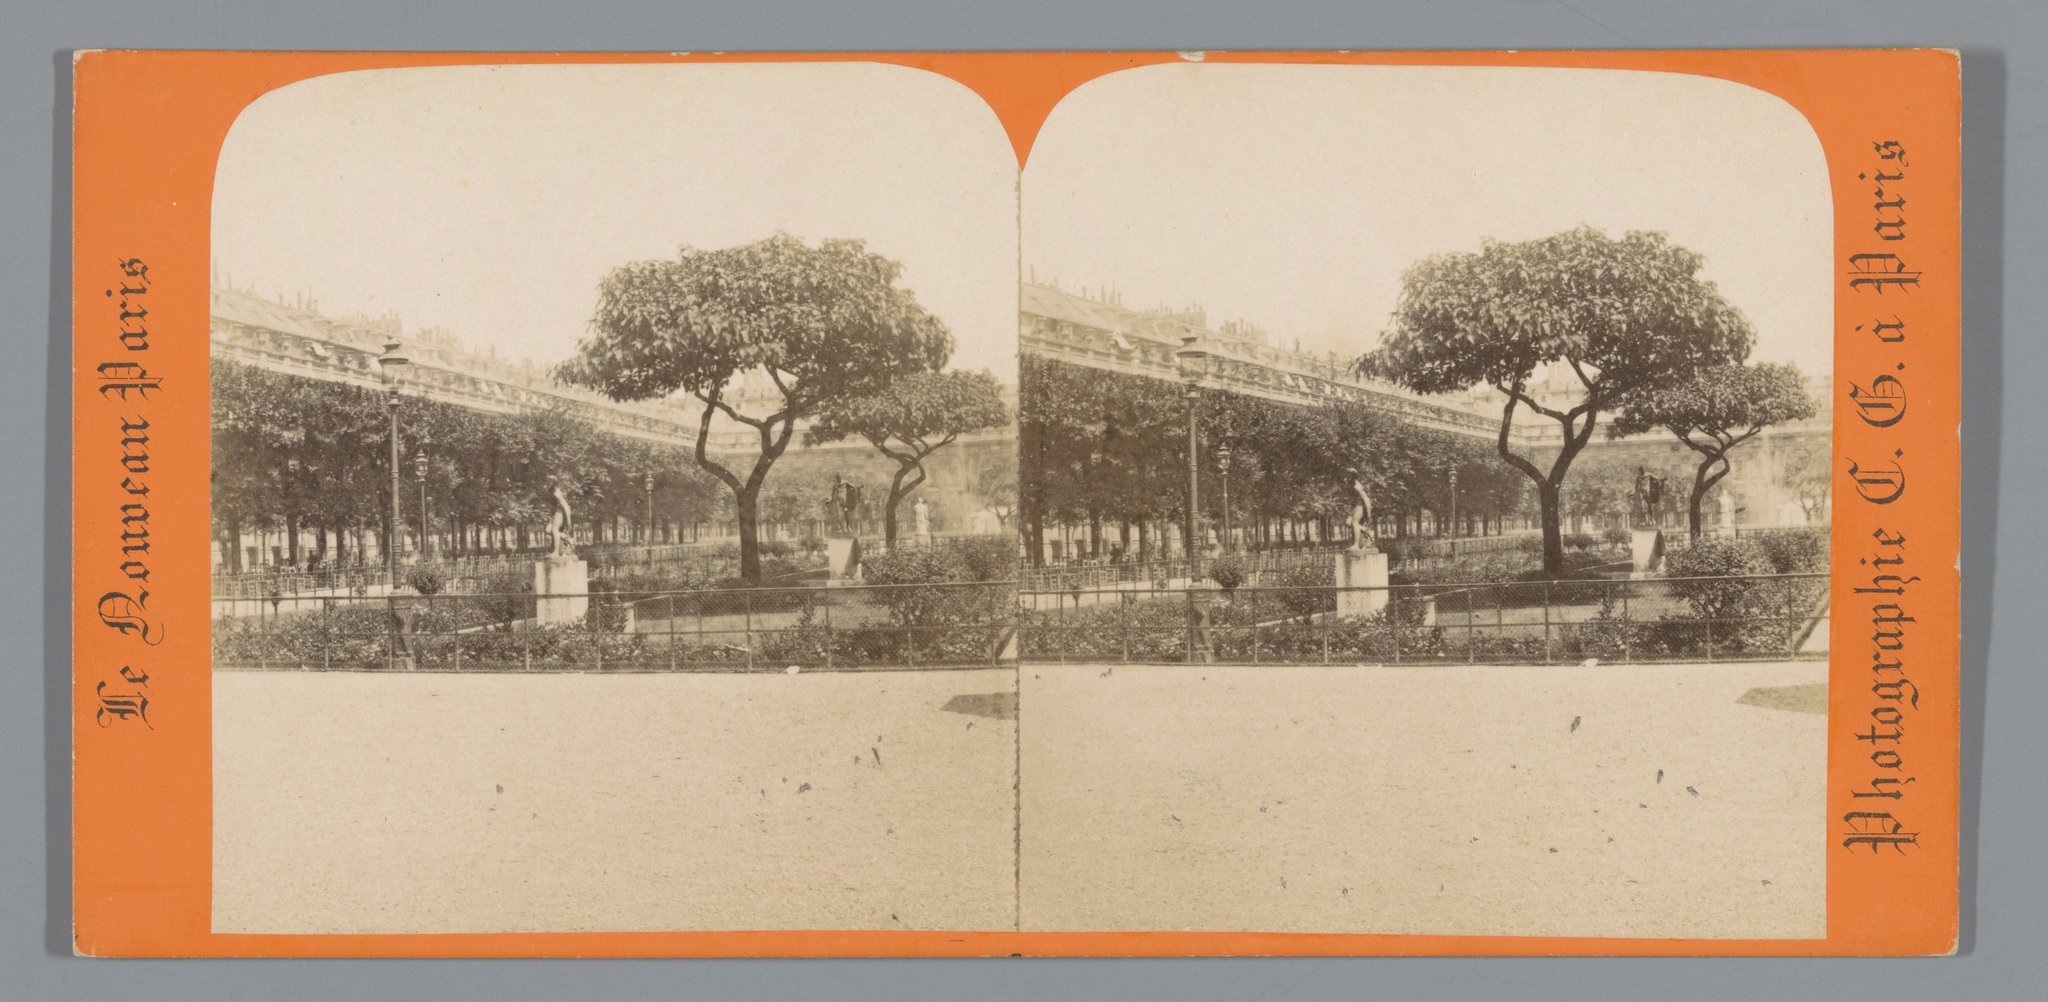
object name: stereograph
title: Tuin van het Palais-Royal te Parijs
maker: charles gérard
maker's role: fotograaf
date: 1860-1870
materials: cardboard, photographic support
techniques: albumen print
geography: paris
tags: french or architectonic garden; formal garden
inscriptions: inscription: ‘Jardin du palais royal’, inscription: ‘Photographie C. G. à Paris.’